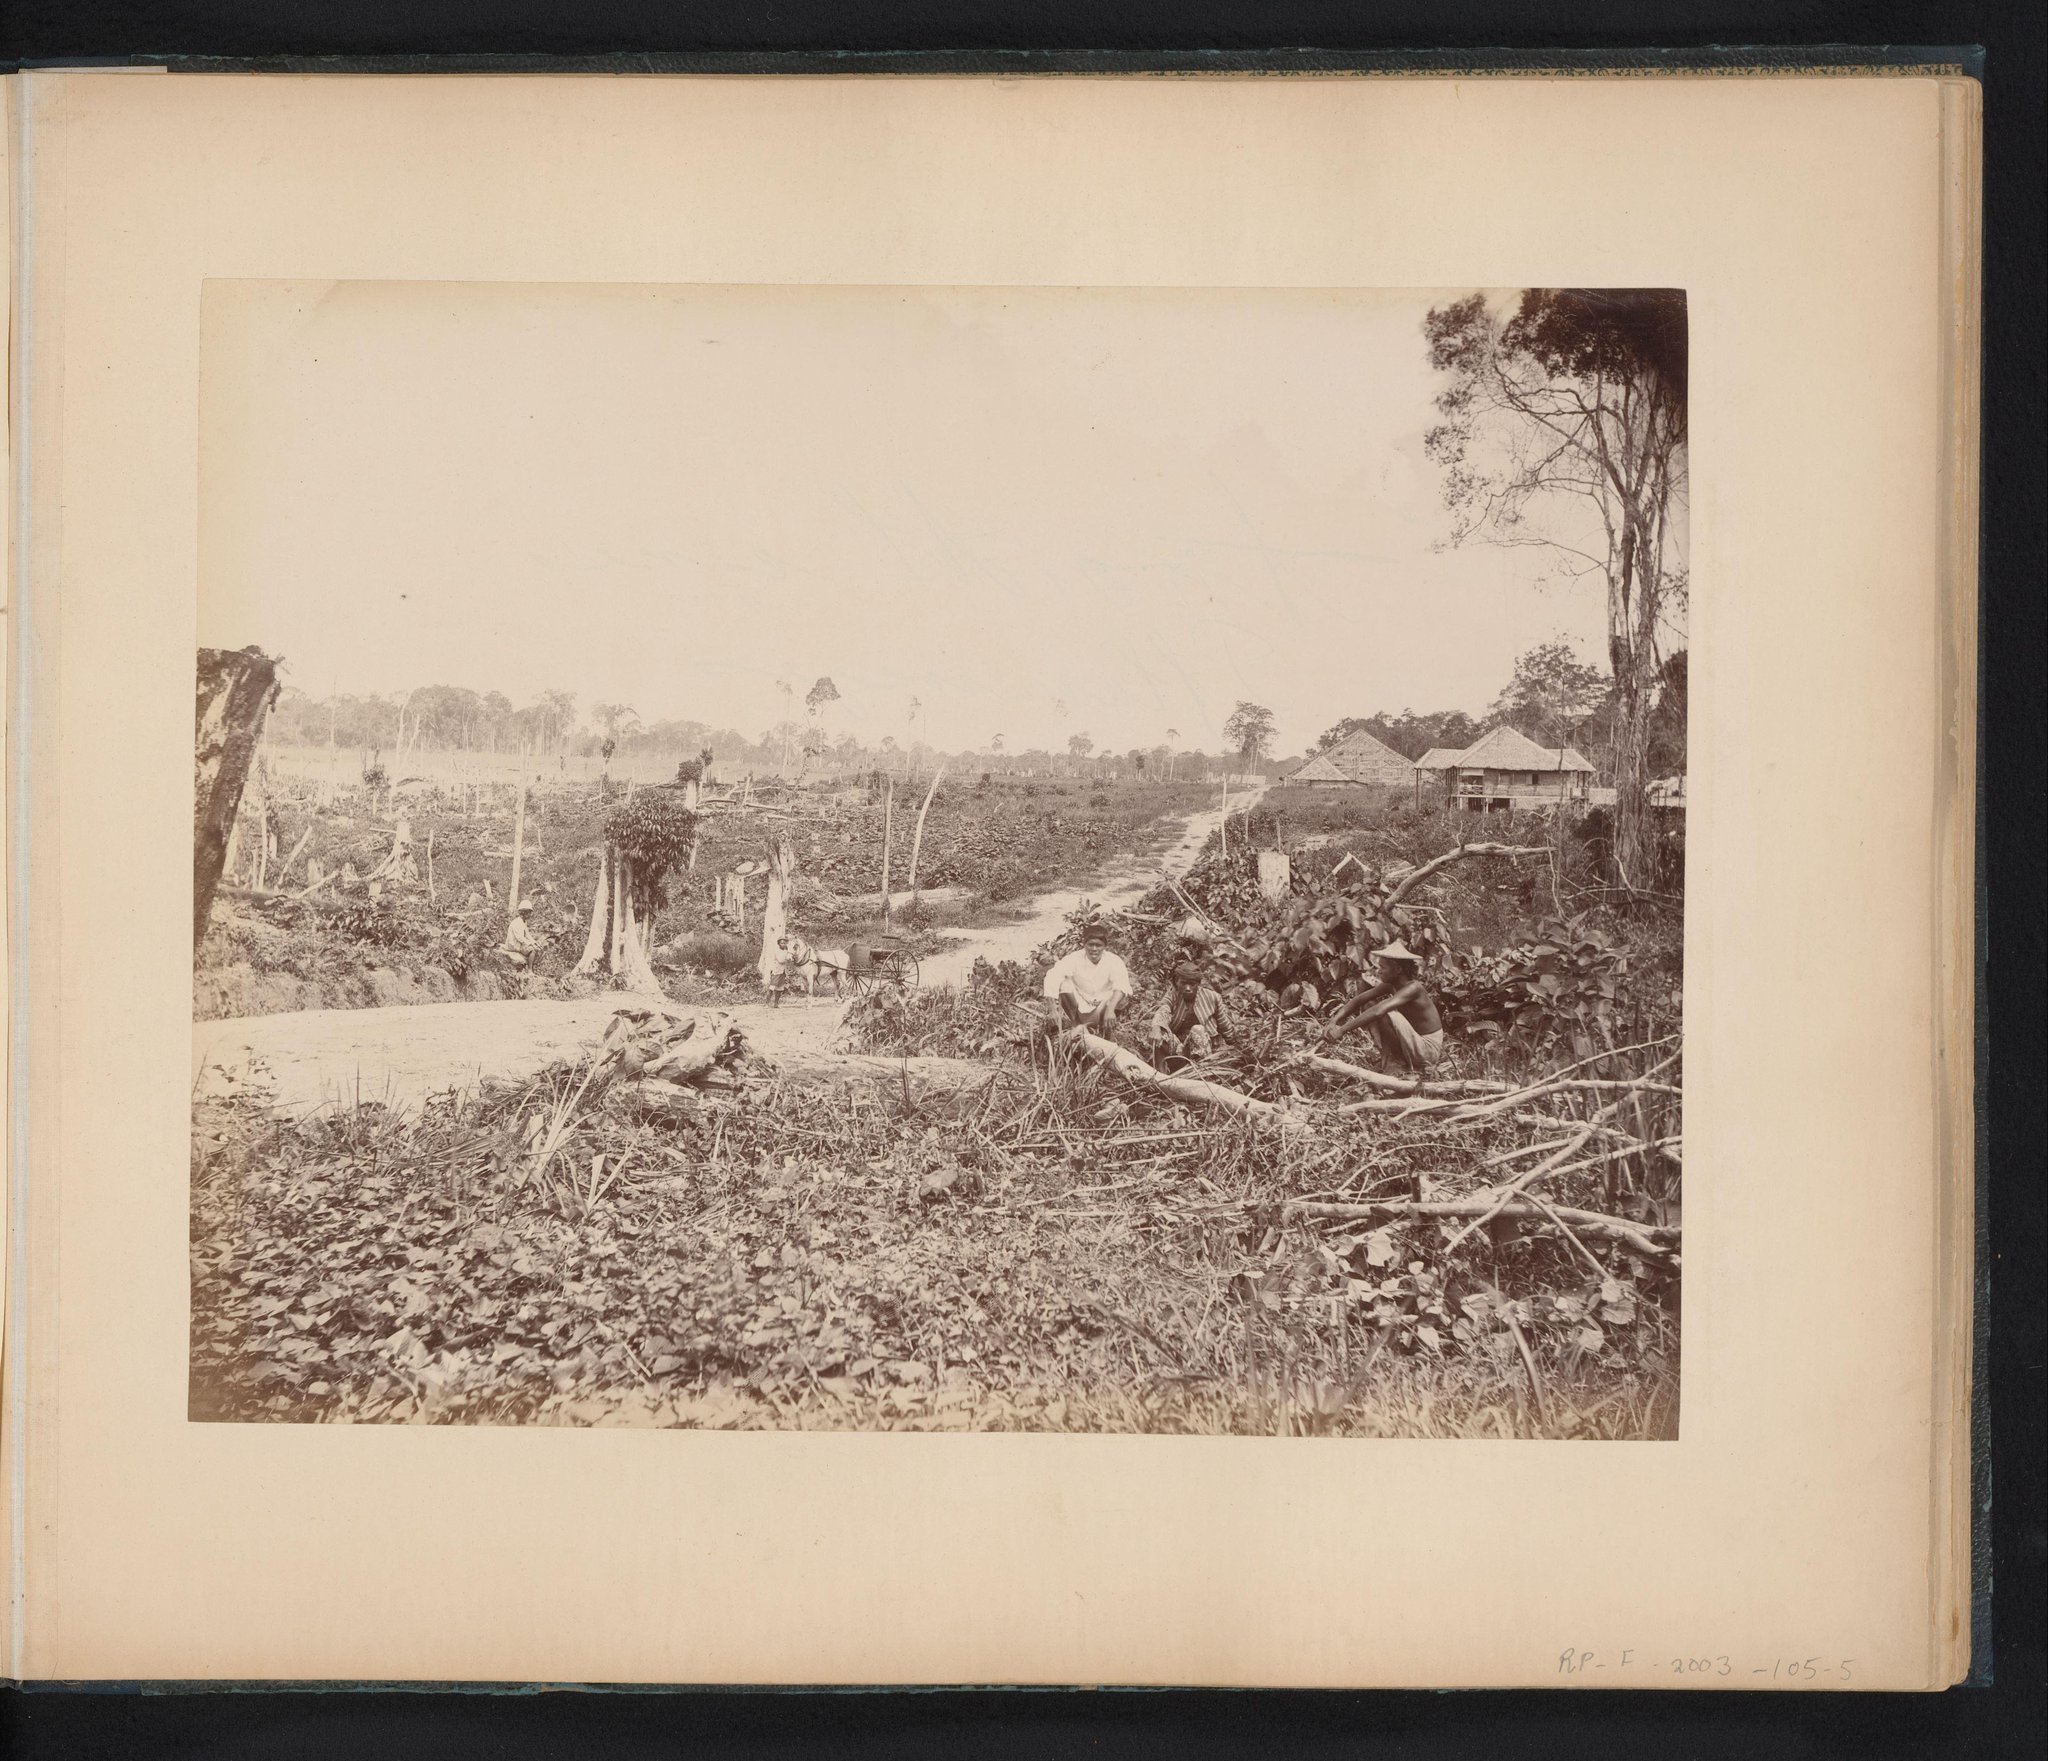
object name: photograph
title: Gezicht op een plantage met gekapte bomen met Javaanse contractarbeiders, vermoedelijk in Langkat, Sumatra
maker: Anonymous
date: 1890-1900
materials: cardboard, photographic support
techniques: albumen print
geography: sumatra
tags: plantation, chopping (industrial process), woodcutting, woodcutter ~ forestry, working class, labourers, sumatra